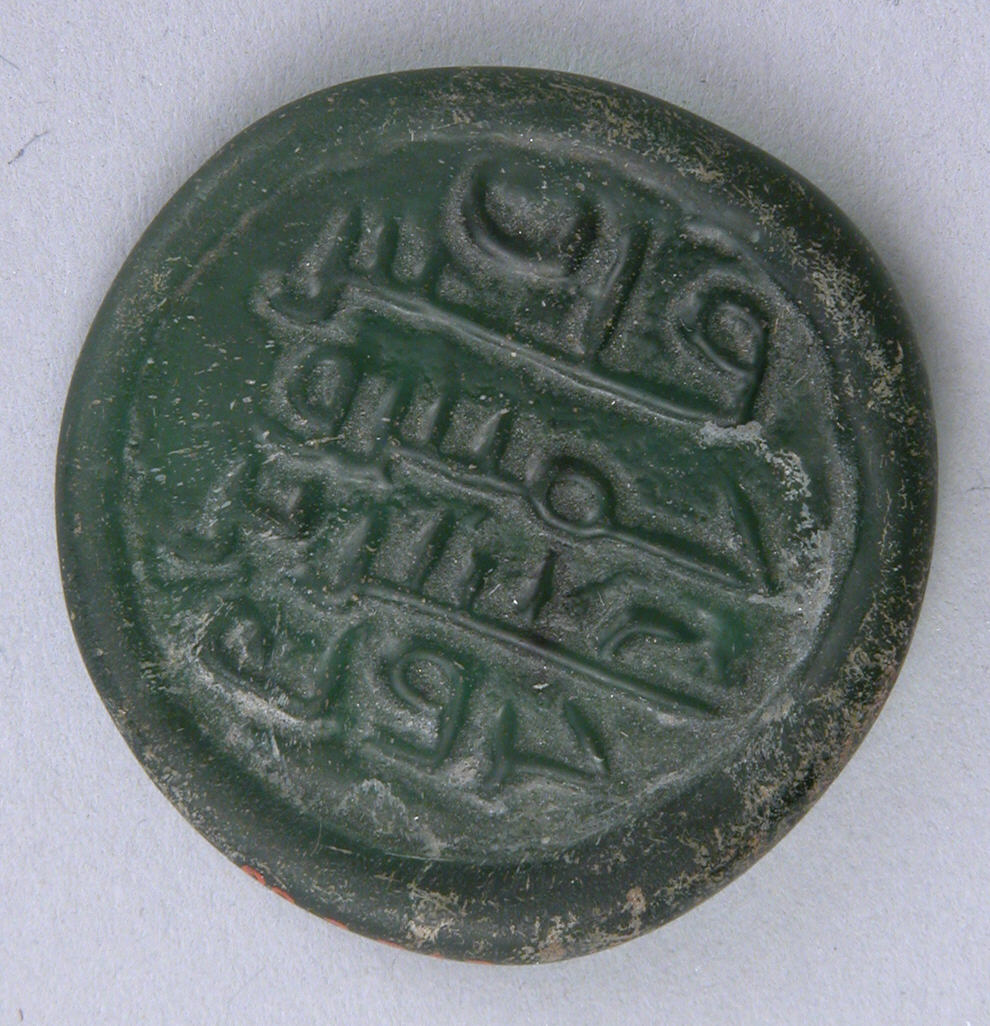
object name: coin weight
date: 701-800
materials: glass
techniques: stamping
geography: egypt